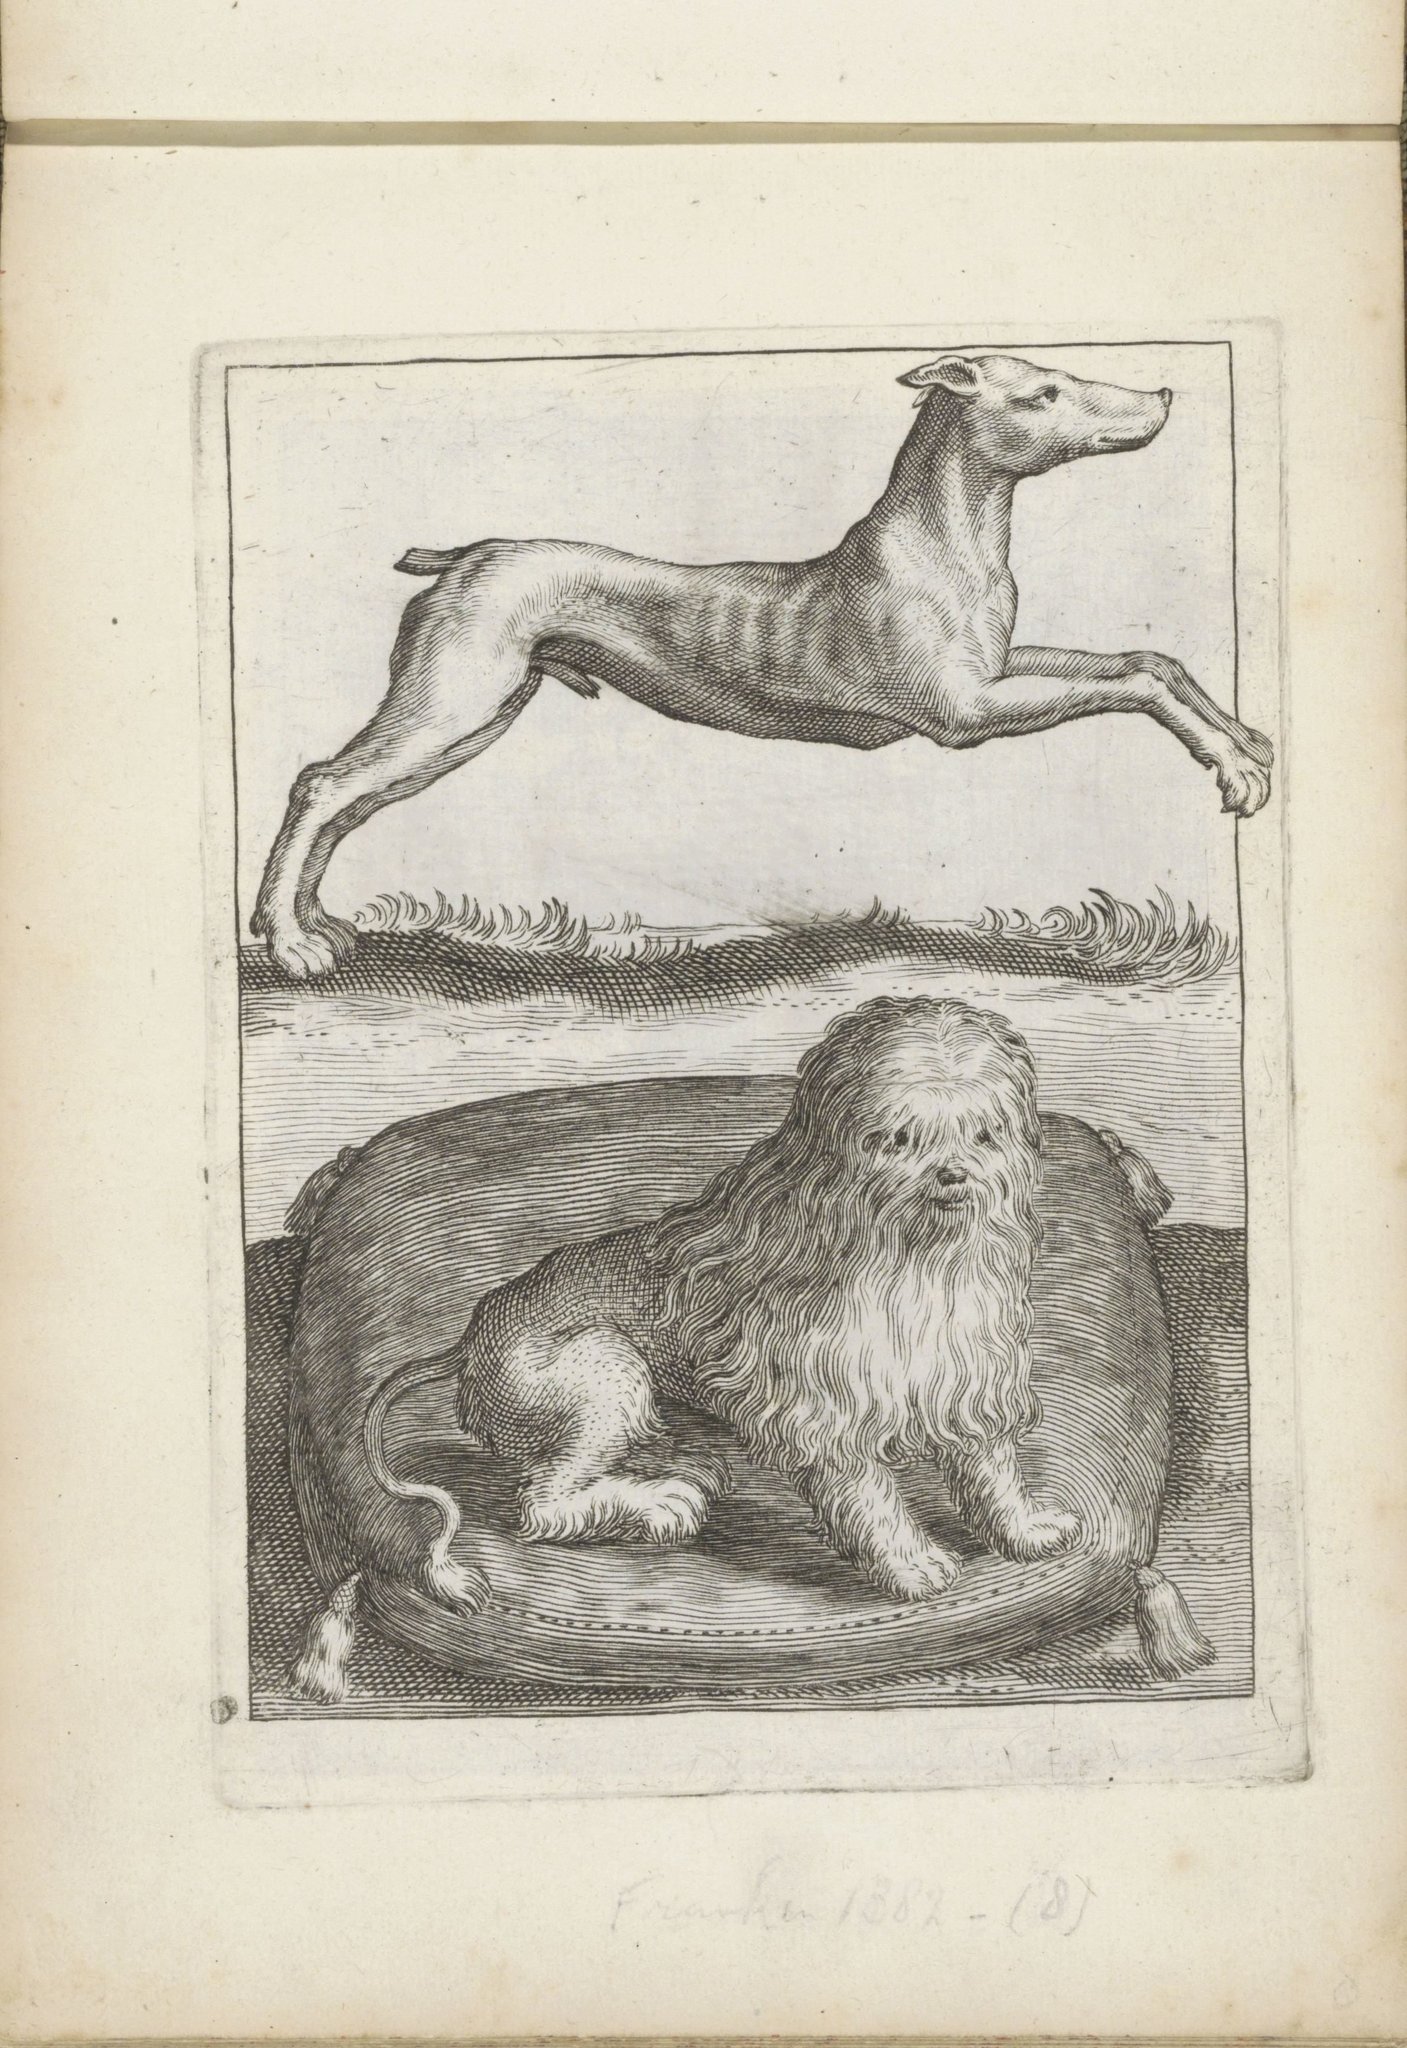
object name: album leaf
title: Bestiarum quadrupedum Vivae Icones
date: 1635-1660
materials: paper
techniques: engraving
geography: utrecht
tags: dog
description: Twee honden. Boven: een rennende hond. Onder: een schoothond op een kussen. Deze prent maakt deel uit van een album.